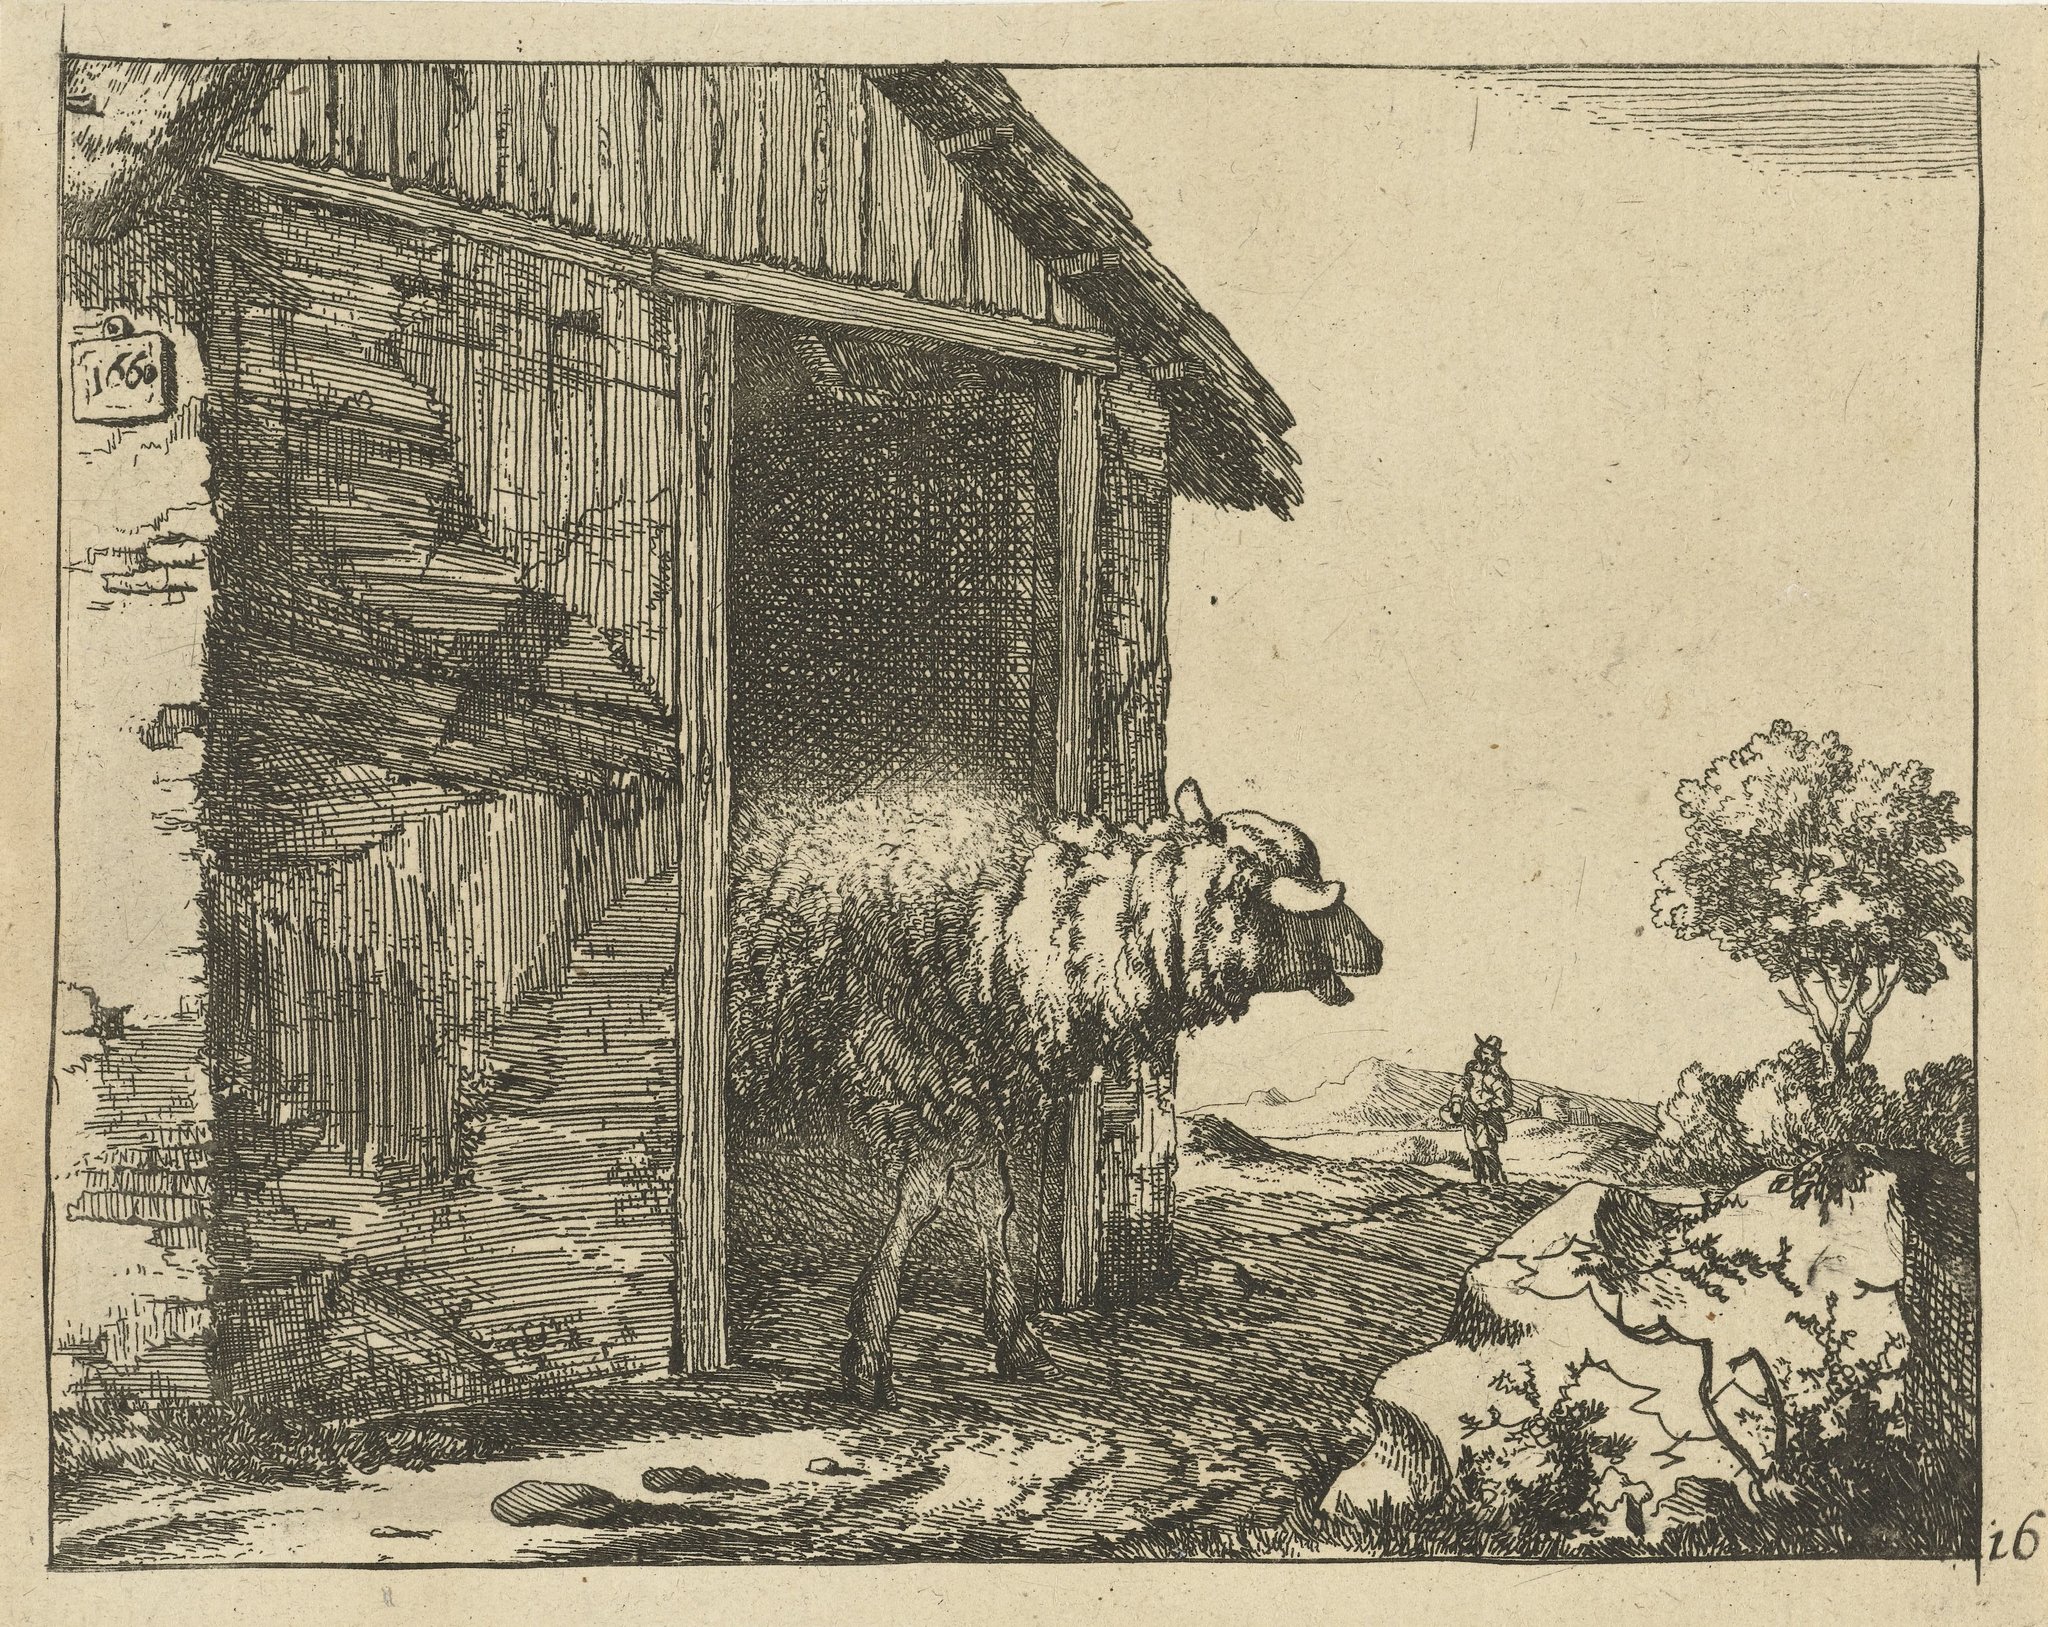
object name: print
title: Schapen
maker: marcus de bye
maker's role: print maker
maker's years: 1639-1688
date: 1660-1664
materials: paper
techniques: etching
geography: the hague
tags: sheep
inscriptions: collector's mark: Lugt 2228